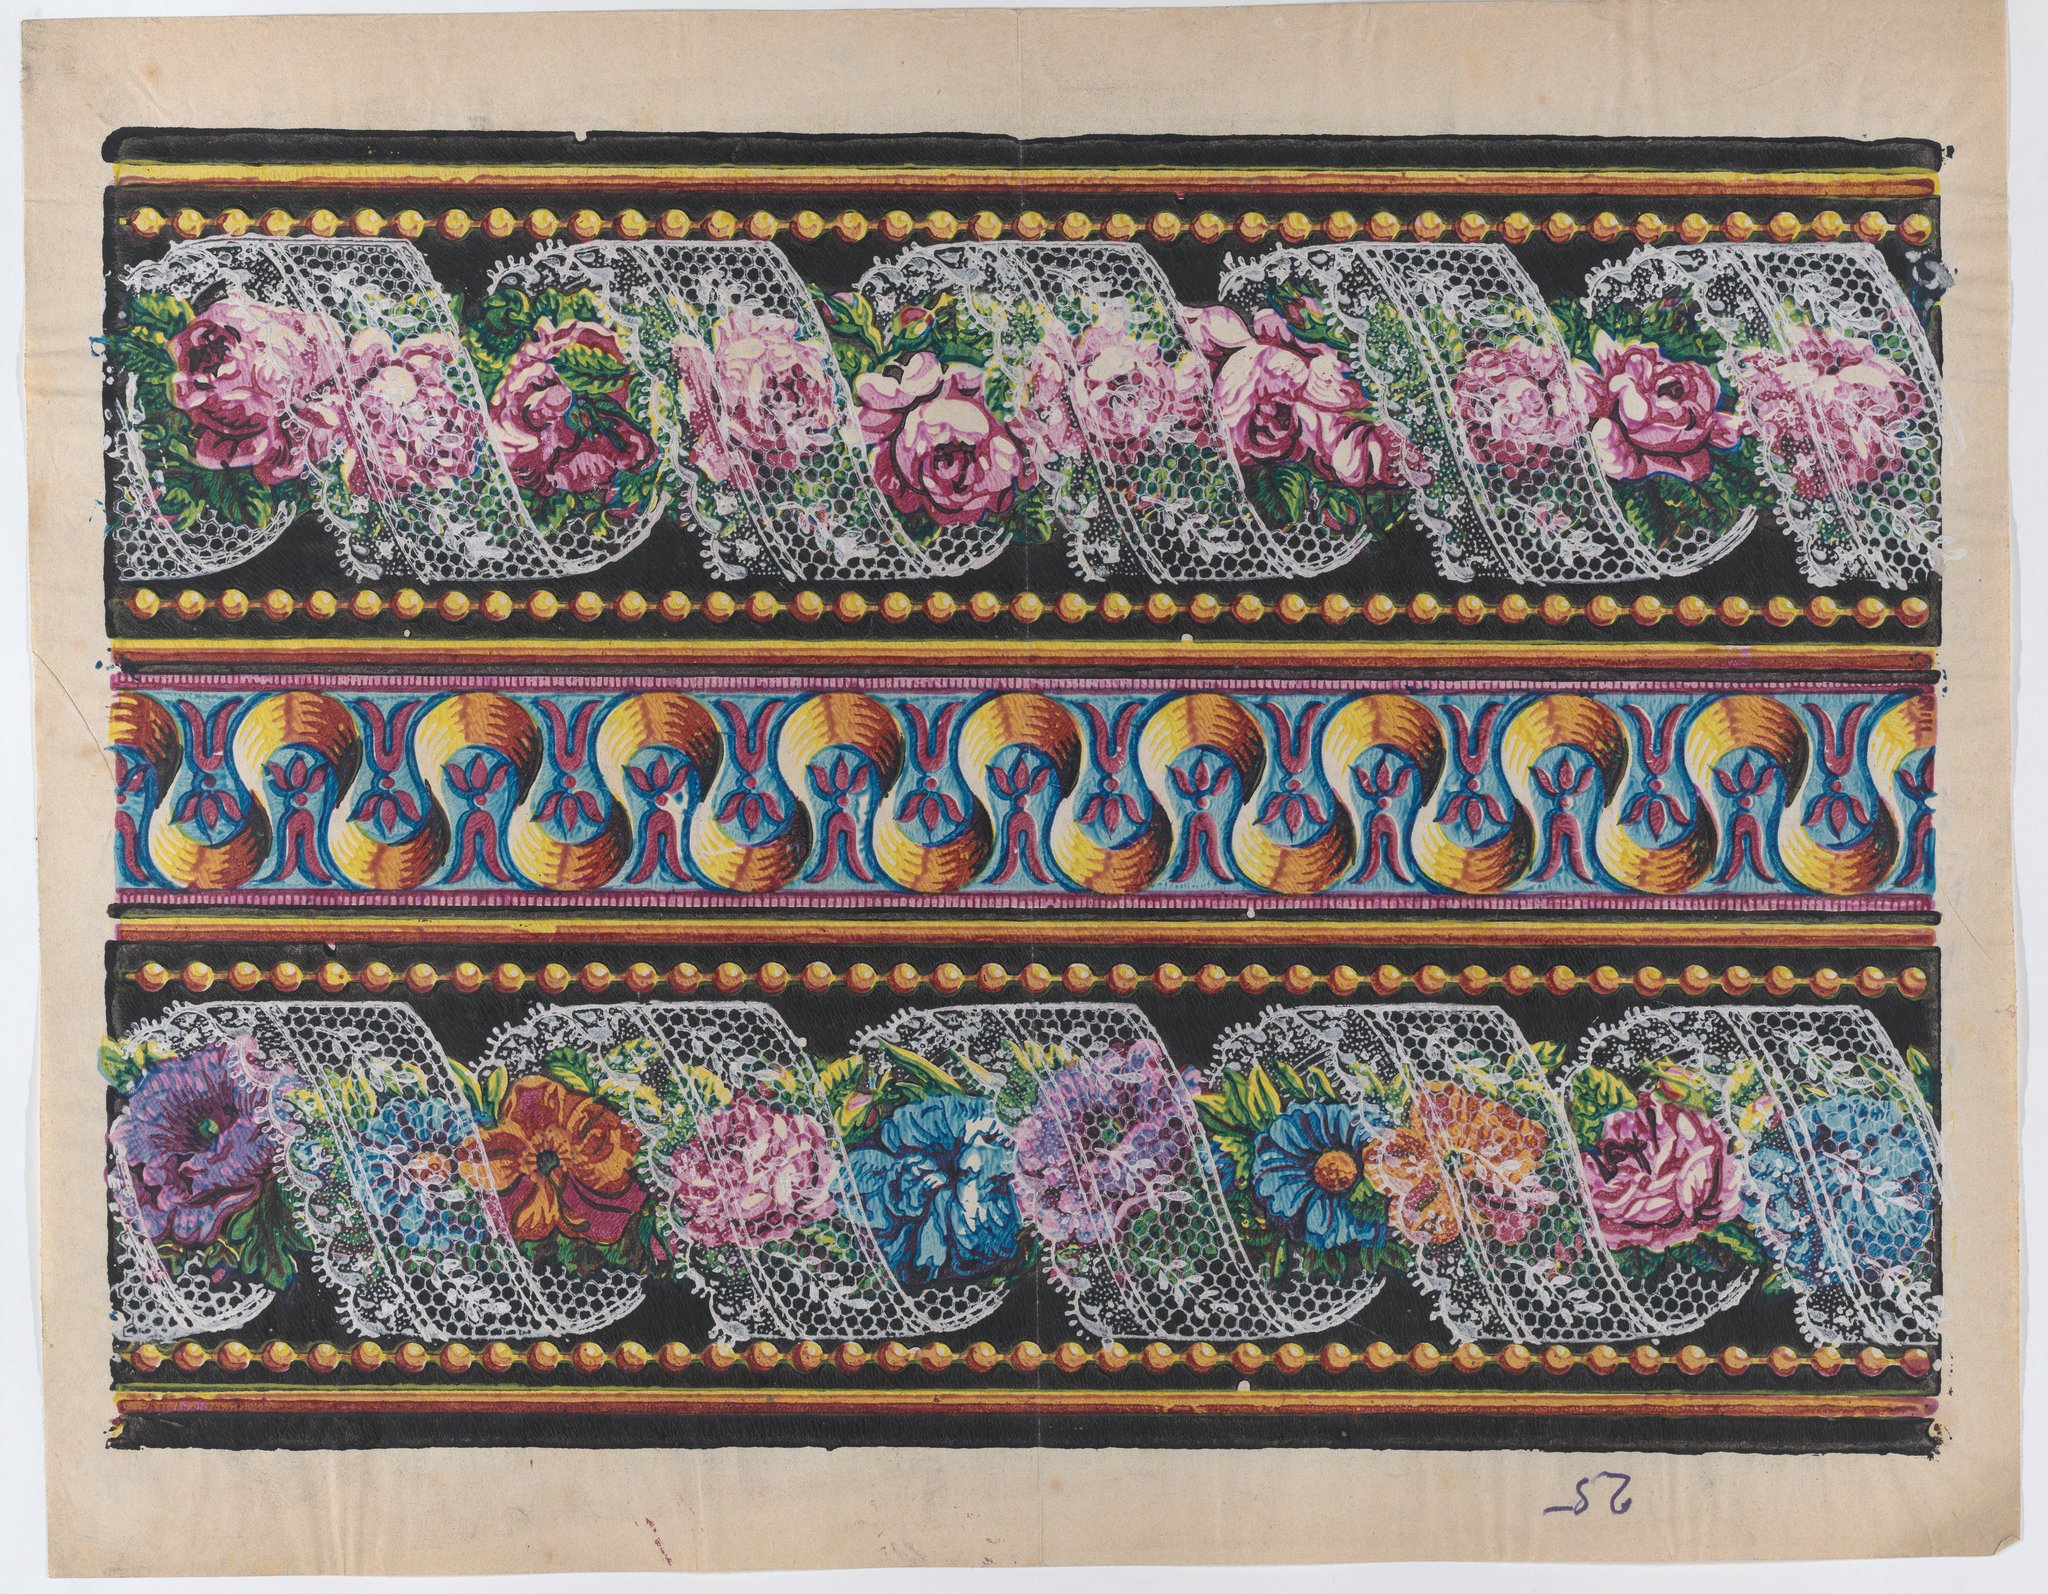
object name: print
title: Sheet with a border with floral garlands and lace on a black background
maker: Anonymous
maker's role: artist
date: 1767-1866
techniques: relief print